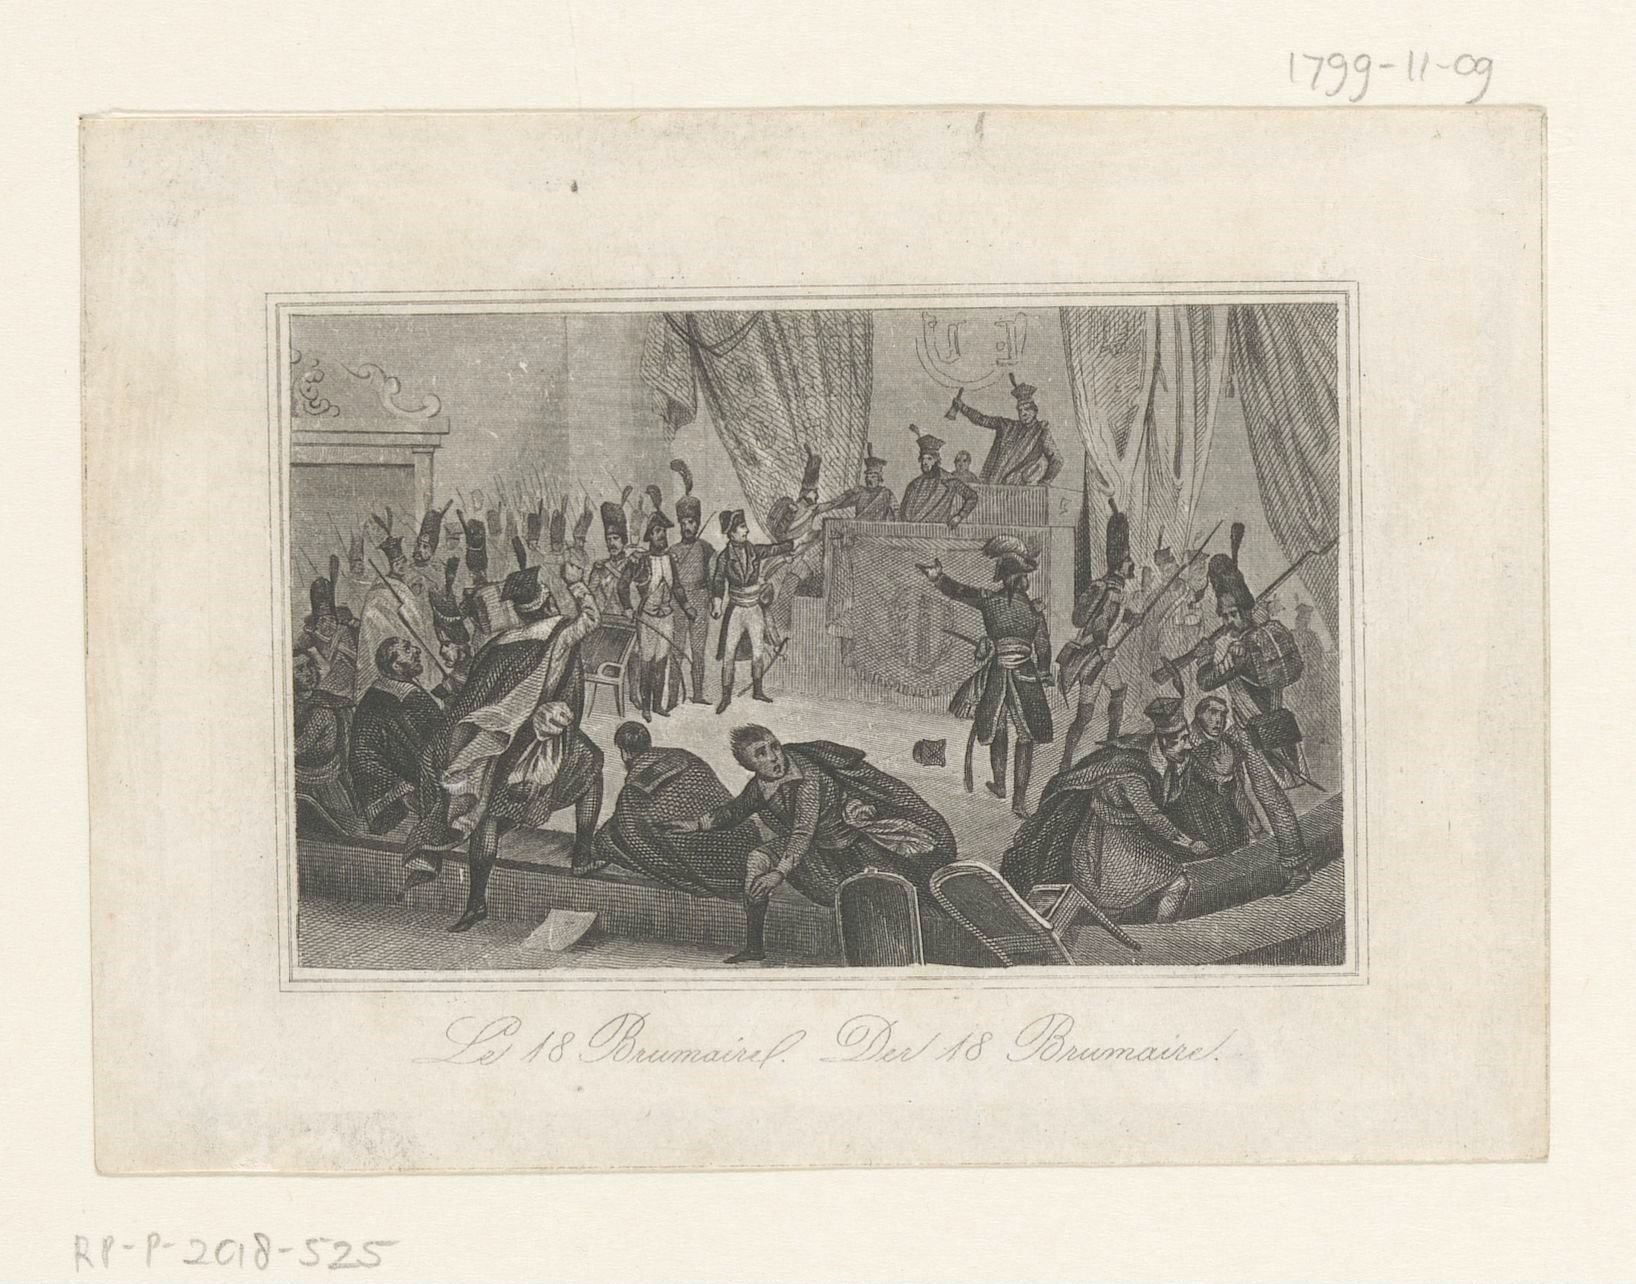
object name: print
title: Le 18 Brumaire. Der 18. Brumaire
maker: Anonymous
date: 1821-1899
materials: paper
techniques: engraving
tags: napoleon i (emperor of the french), proclamation of new government, paris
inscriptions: collector's mark: Lugt 2228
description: Staatsgreep van 18 Brumaire waarin Napoleon de macht grijpt in revolutionair Frankrijk, 9 november 1799. Onder de voorstelling de titels in het Frans en Duits. Onderdeel van een groep van twaalf illustraties.